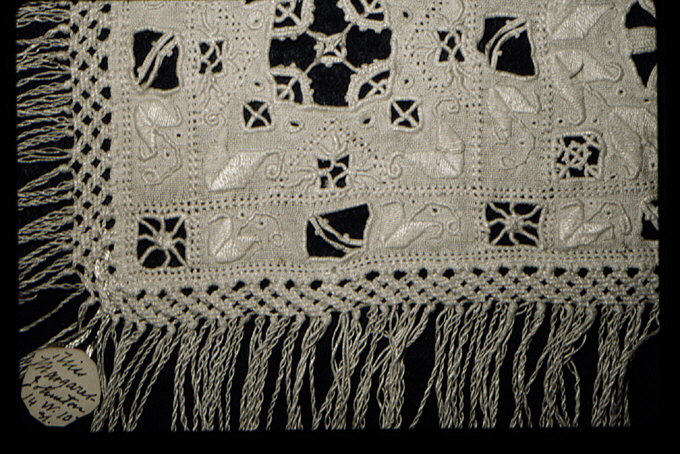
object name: border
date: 1501-1600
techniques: embroidery